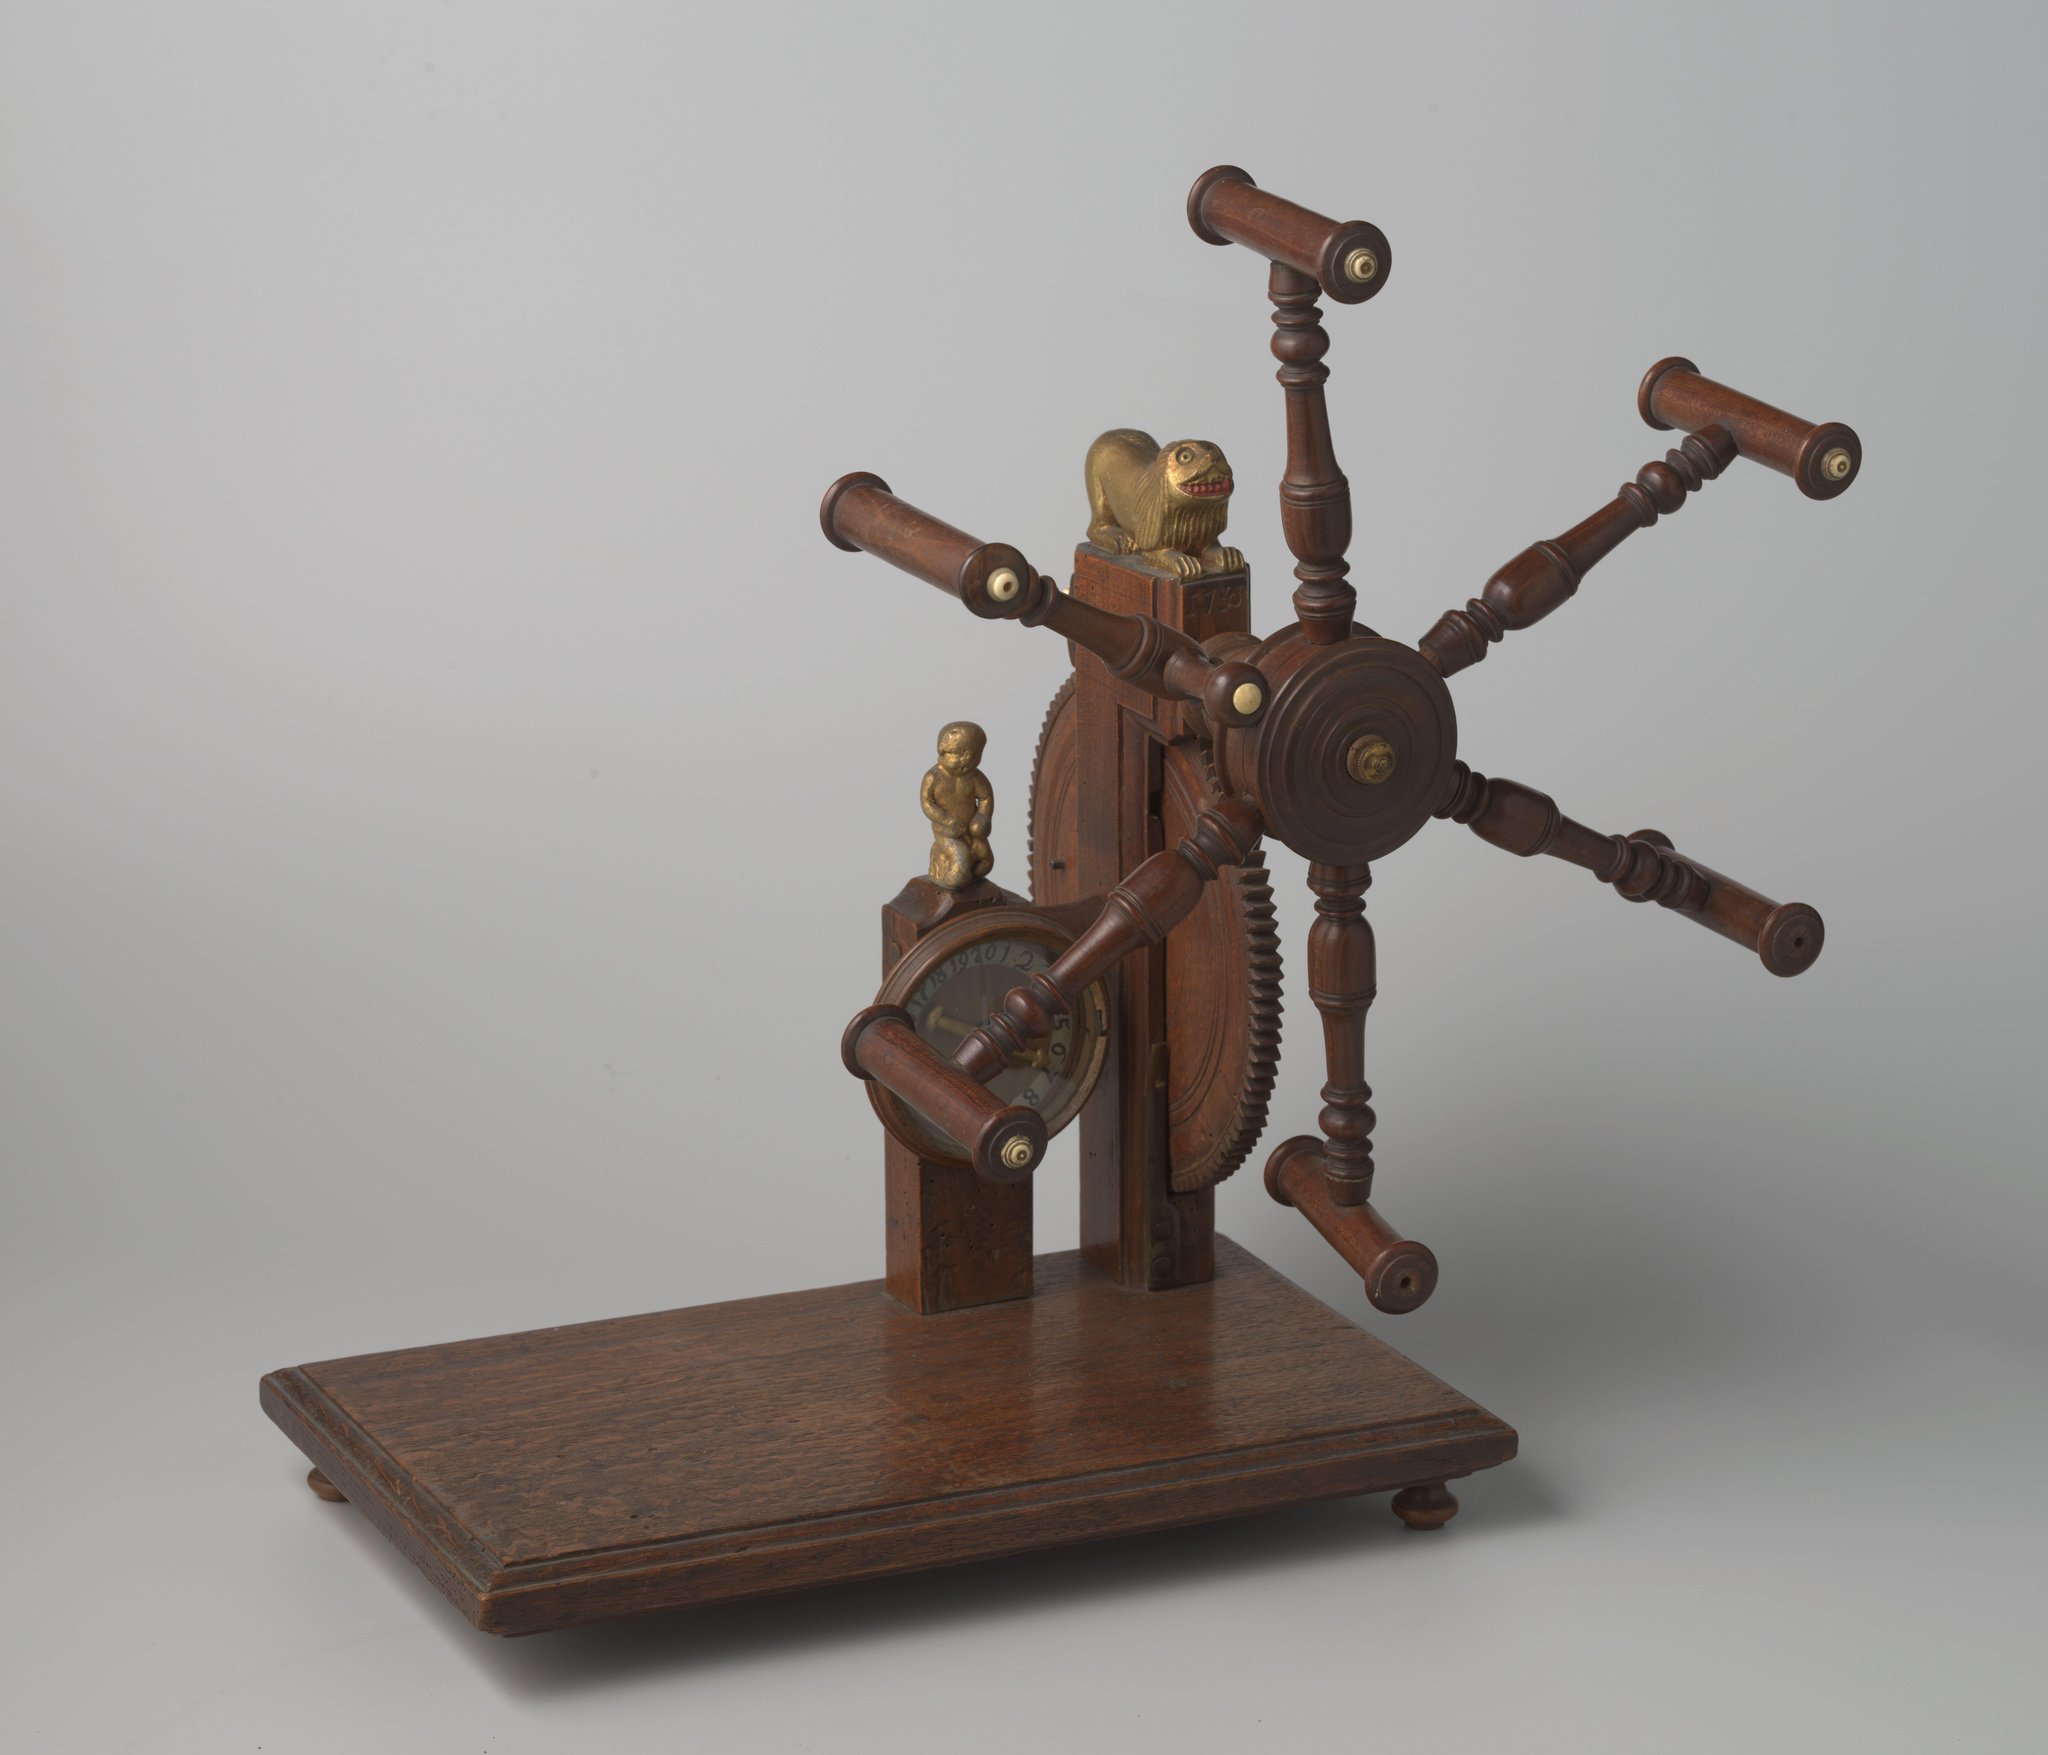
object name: textile working equipment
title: Garenwinder van hout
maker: Anonymous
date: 1736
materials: bone, wood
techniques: turning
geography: western europe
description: Een garenwinder van hout. Op een rechthoekige basis staat een houder waarin een gekarteld wiel; bovenop de houder is een liggende leeuw geplaatst. Aan de zijkant van de houder is een meter bevestigd, waar een kleine jongen op staat. Dwars op de houder is een arm geplaatst waaraan de spoelen zitten waaromheen het garen gewonden kan worden. Drie spoelen zijn afgebroken.